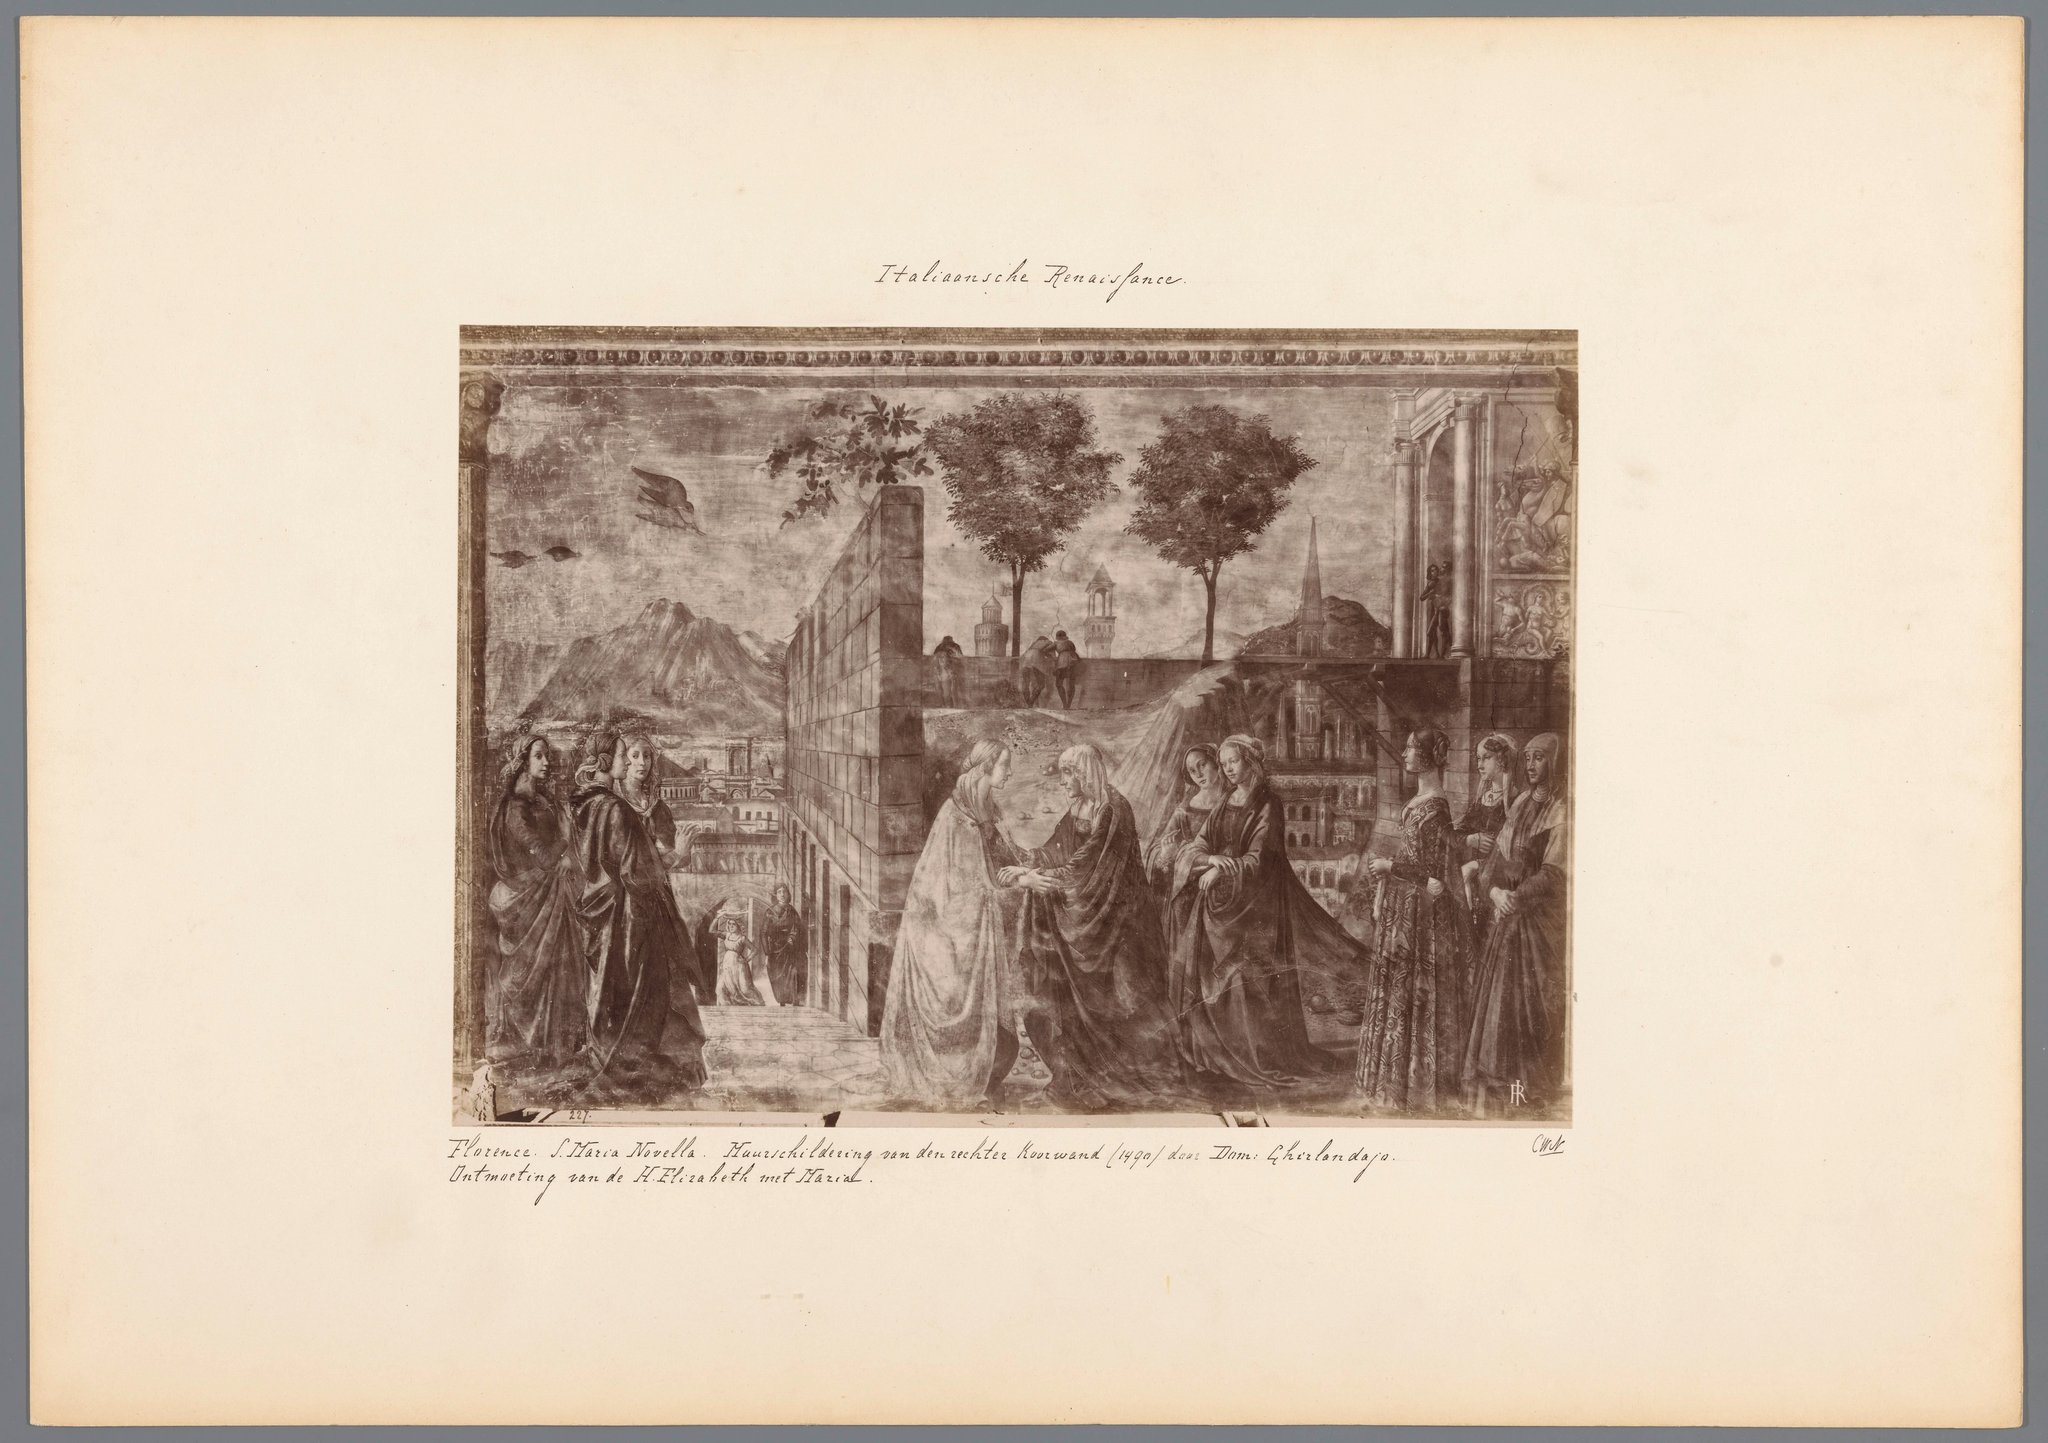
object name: photograph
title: Florence. S. Maria Novella. Muurschildeirng van den rechter Koorwand (1490) door Dom: Ghirlandajo.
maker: Anonymous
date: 1875-1900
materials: cardboard, photographic support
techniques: albumen print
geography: santa maria novella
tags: mary and elisabeth shaking hands, painting (including book-illumination, miniature-painting) (+ plaster ~ arts)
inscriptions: inscription: ‘Italiaansche Renaissance.’, collector's mark: ‘KUNSTNIJVERHEIDSCHOOL QUELLINUS AMSTERDAM FRANS HALSSTRAAT 14.’, inscription: ‘IR’, inscription: ‘CWN.’, number: ‘227.’, collector's mark: ‘INSTITUUT VOOR KUNST-NIJVERHEIDSONDERWIJS GABRIËL METSUSTRAAT No. 16 AMSTERDAM’